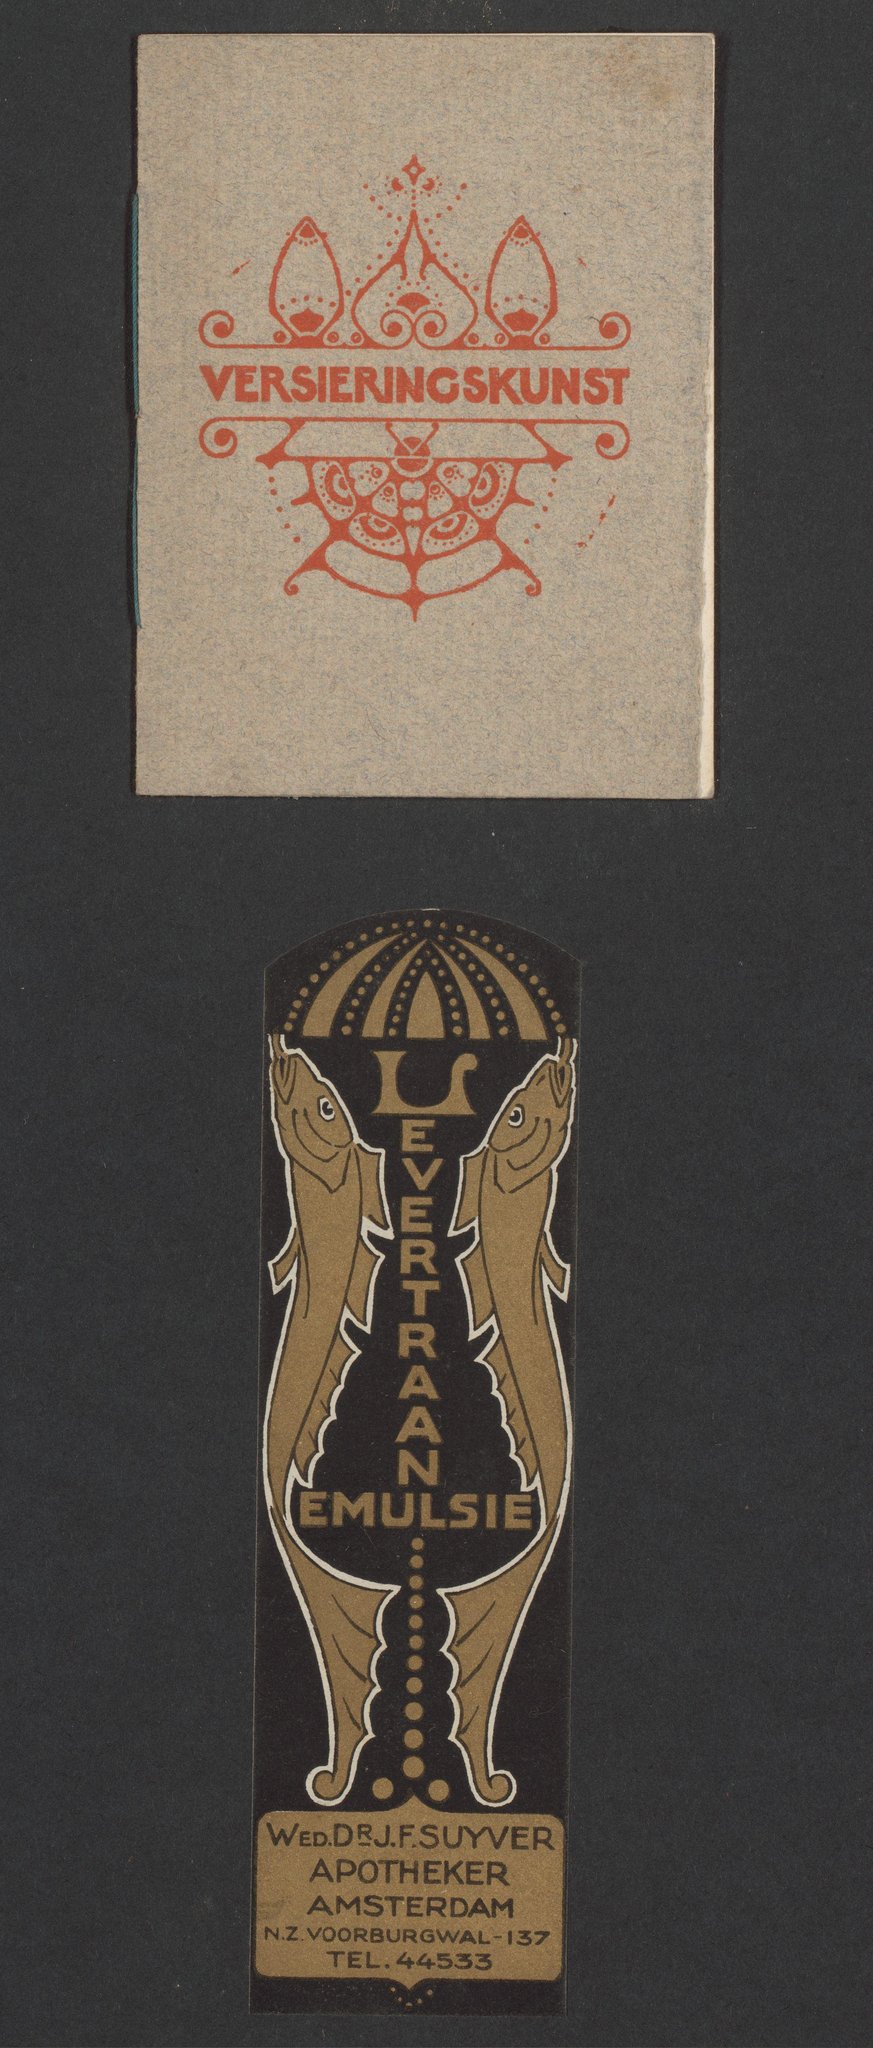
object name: print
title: Reclameboekje voor lessen in Versieringskunst door R.W.P. de Vries Jr. en een apothekersetiket voor levertraanemulsie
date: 1884-1952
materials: paper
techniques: lithograph, printing block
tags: fishes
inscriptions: number: ‘No26'27'’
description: Ornamenten rondom het woord 'versieringskunst' en een etiket met twee vissen aan weerszijden van de woorden 'levertraan' en 'emulsie'.